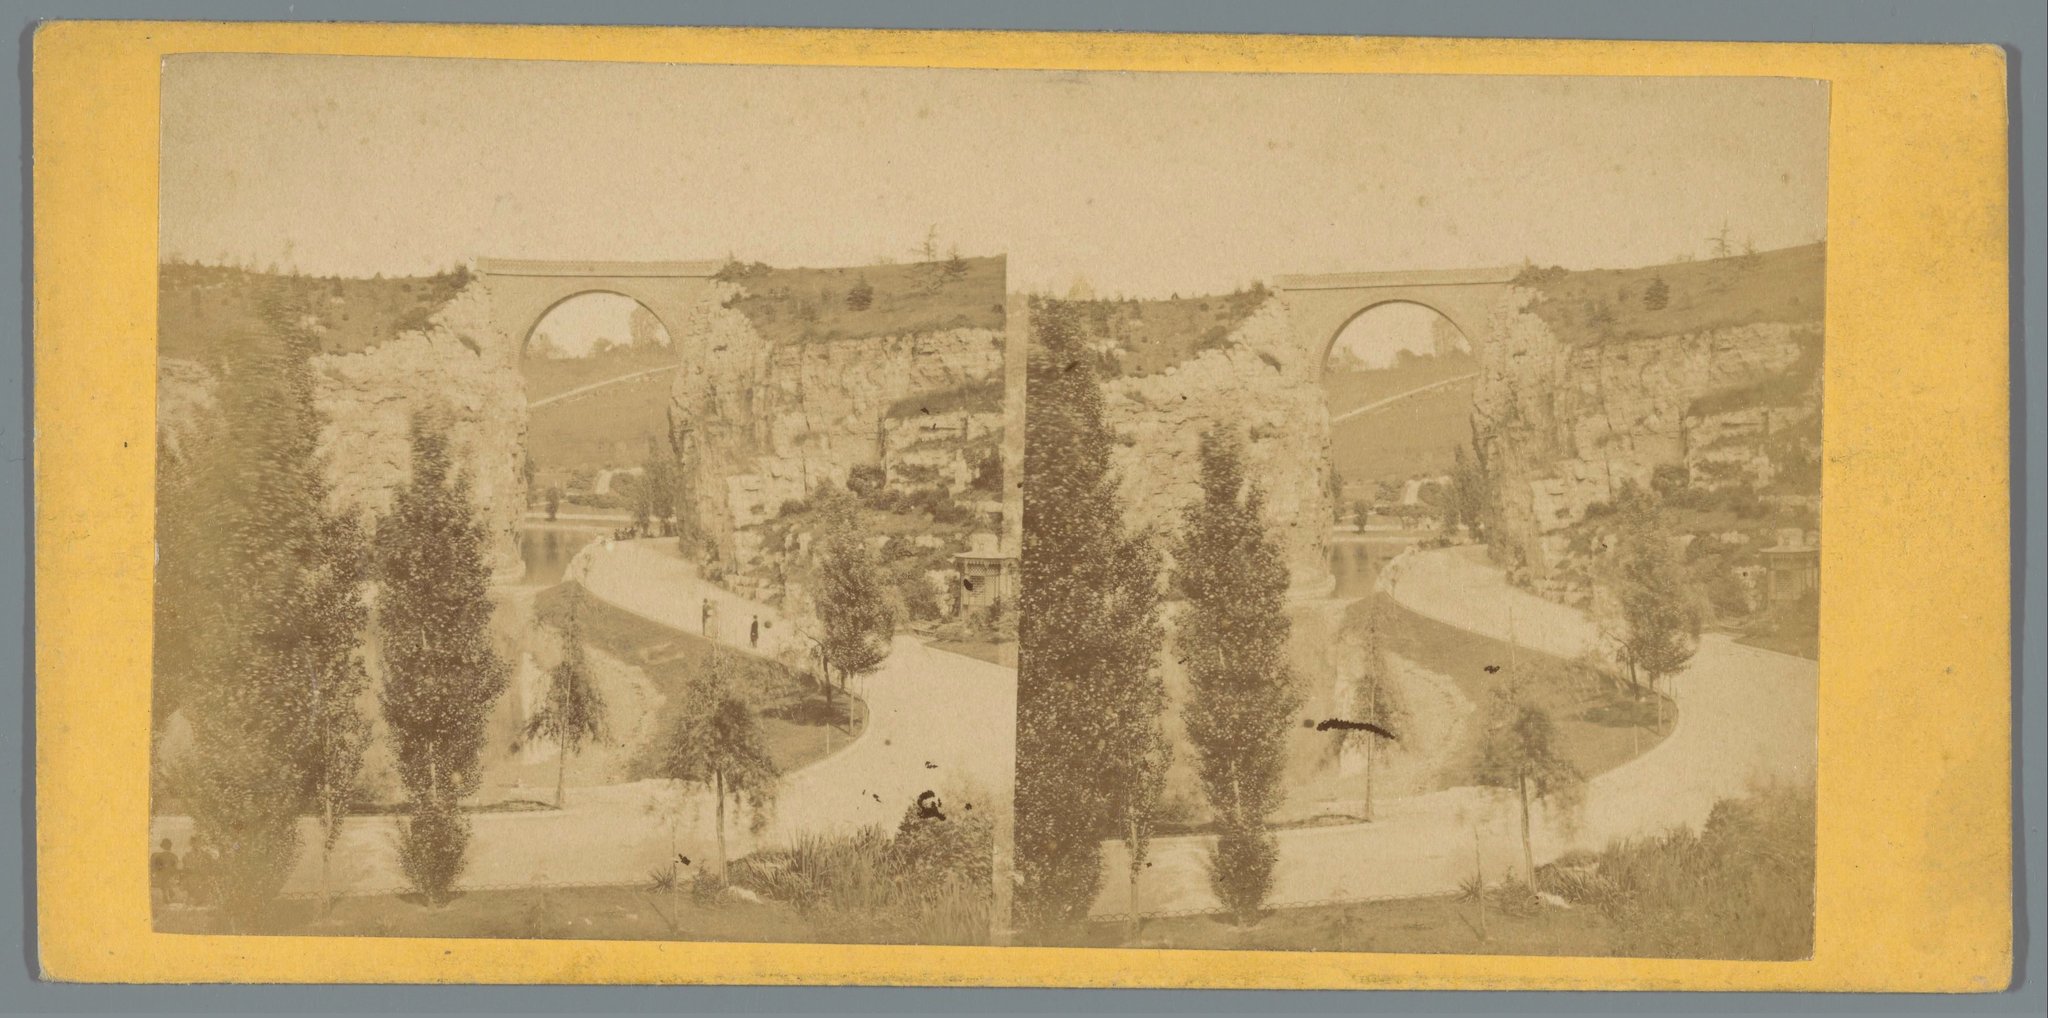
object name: stereograph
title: Gezicht op een brug in het Parc des Buttes-Chaumont in Parijs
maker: Anonymous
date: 1850-1880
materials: cardboard, photographic support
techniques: albumen print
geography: parc des buttes-chaumont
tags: bridge, public gardens, park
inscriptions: inscription: ‘Buttes-Chaumont’